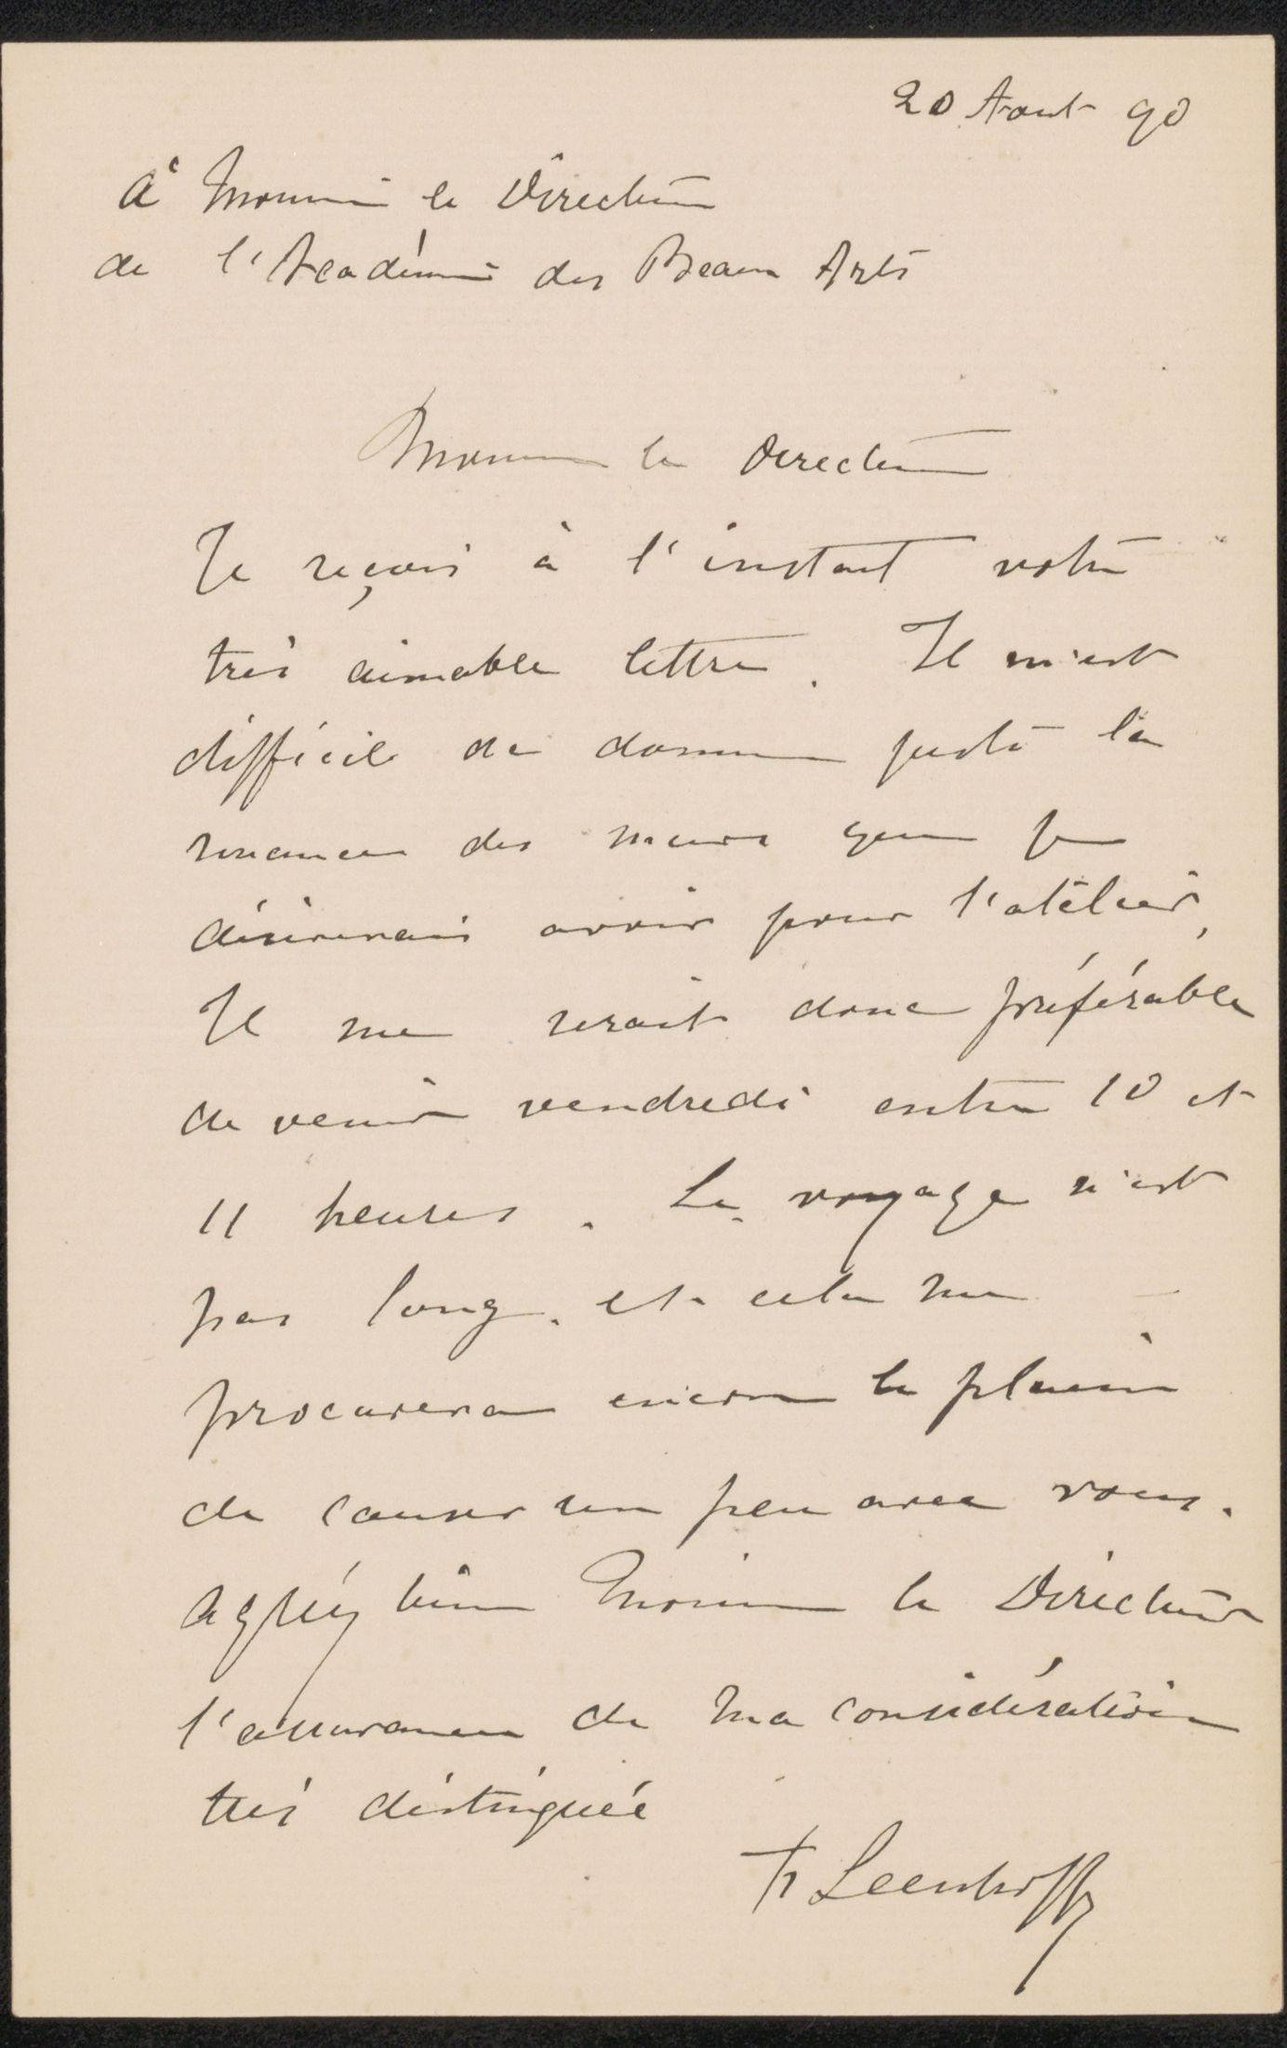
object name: letter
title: Brief aan August Allebé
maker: ferdinand leenhoff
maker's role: print maker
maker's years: 1841-1914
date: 1890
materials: ink, paper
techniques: pen, writing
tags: amsterdam, draughtsman, august allebé, workshop, studio of the artist (in general)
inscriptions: watermark